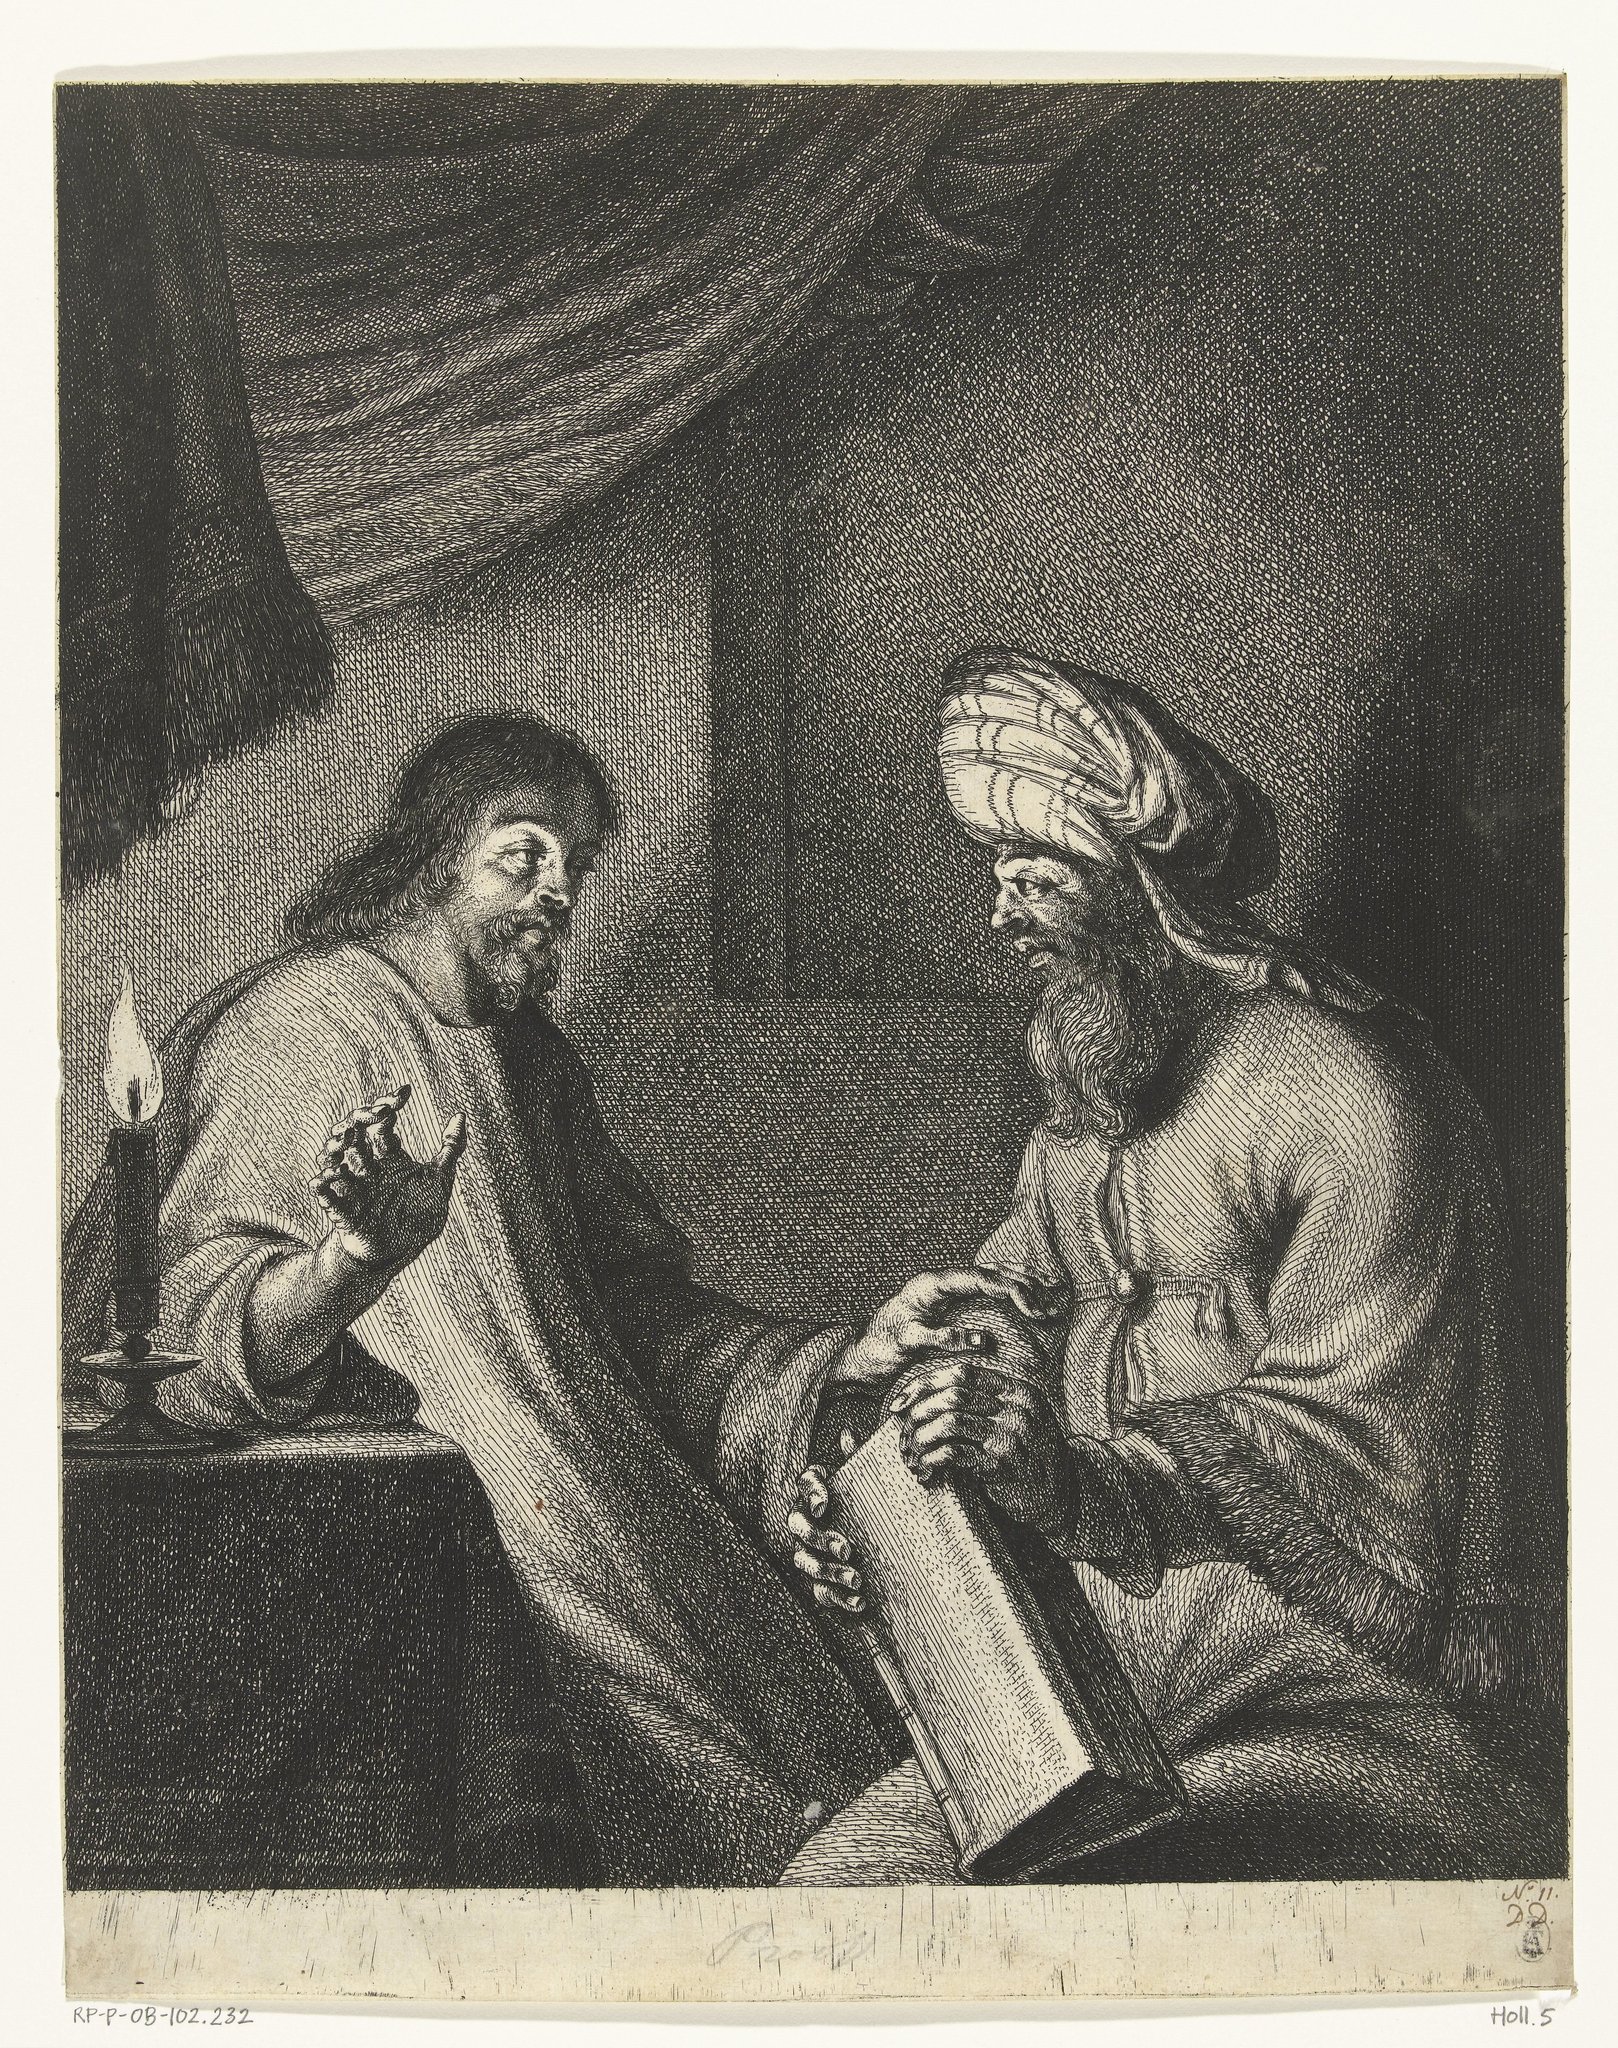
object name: print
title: Christus in gesprek met Nikodemus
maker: pieter fransz de grebber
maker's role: painter, print maker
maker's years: 1600-1653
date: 1610-1655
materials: paper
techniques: etching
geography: netherlands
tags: christ talking with nicodemus at night (john 3:1-21)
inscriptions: collector's mark: Lugt 2228, collector's mark: Lugt 971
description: Prent naar schilderij van Rembrandt Harmensz. van Rijn.